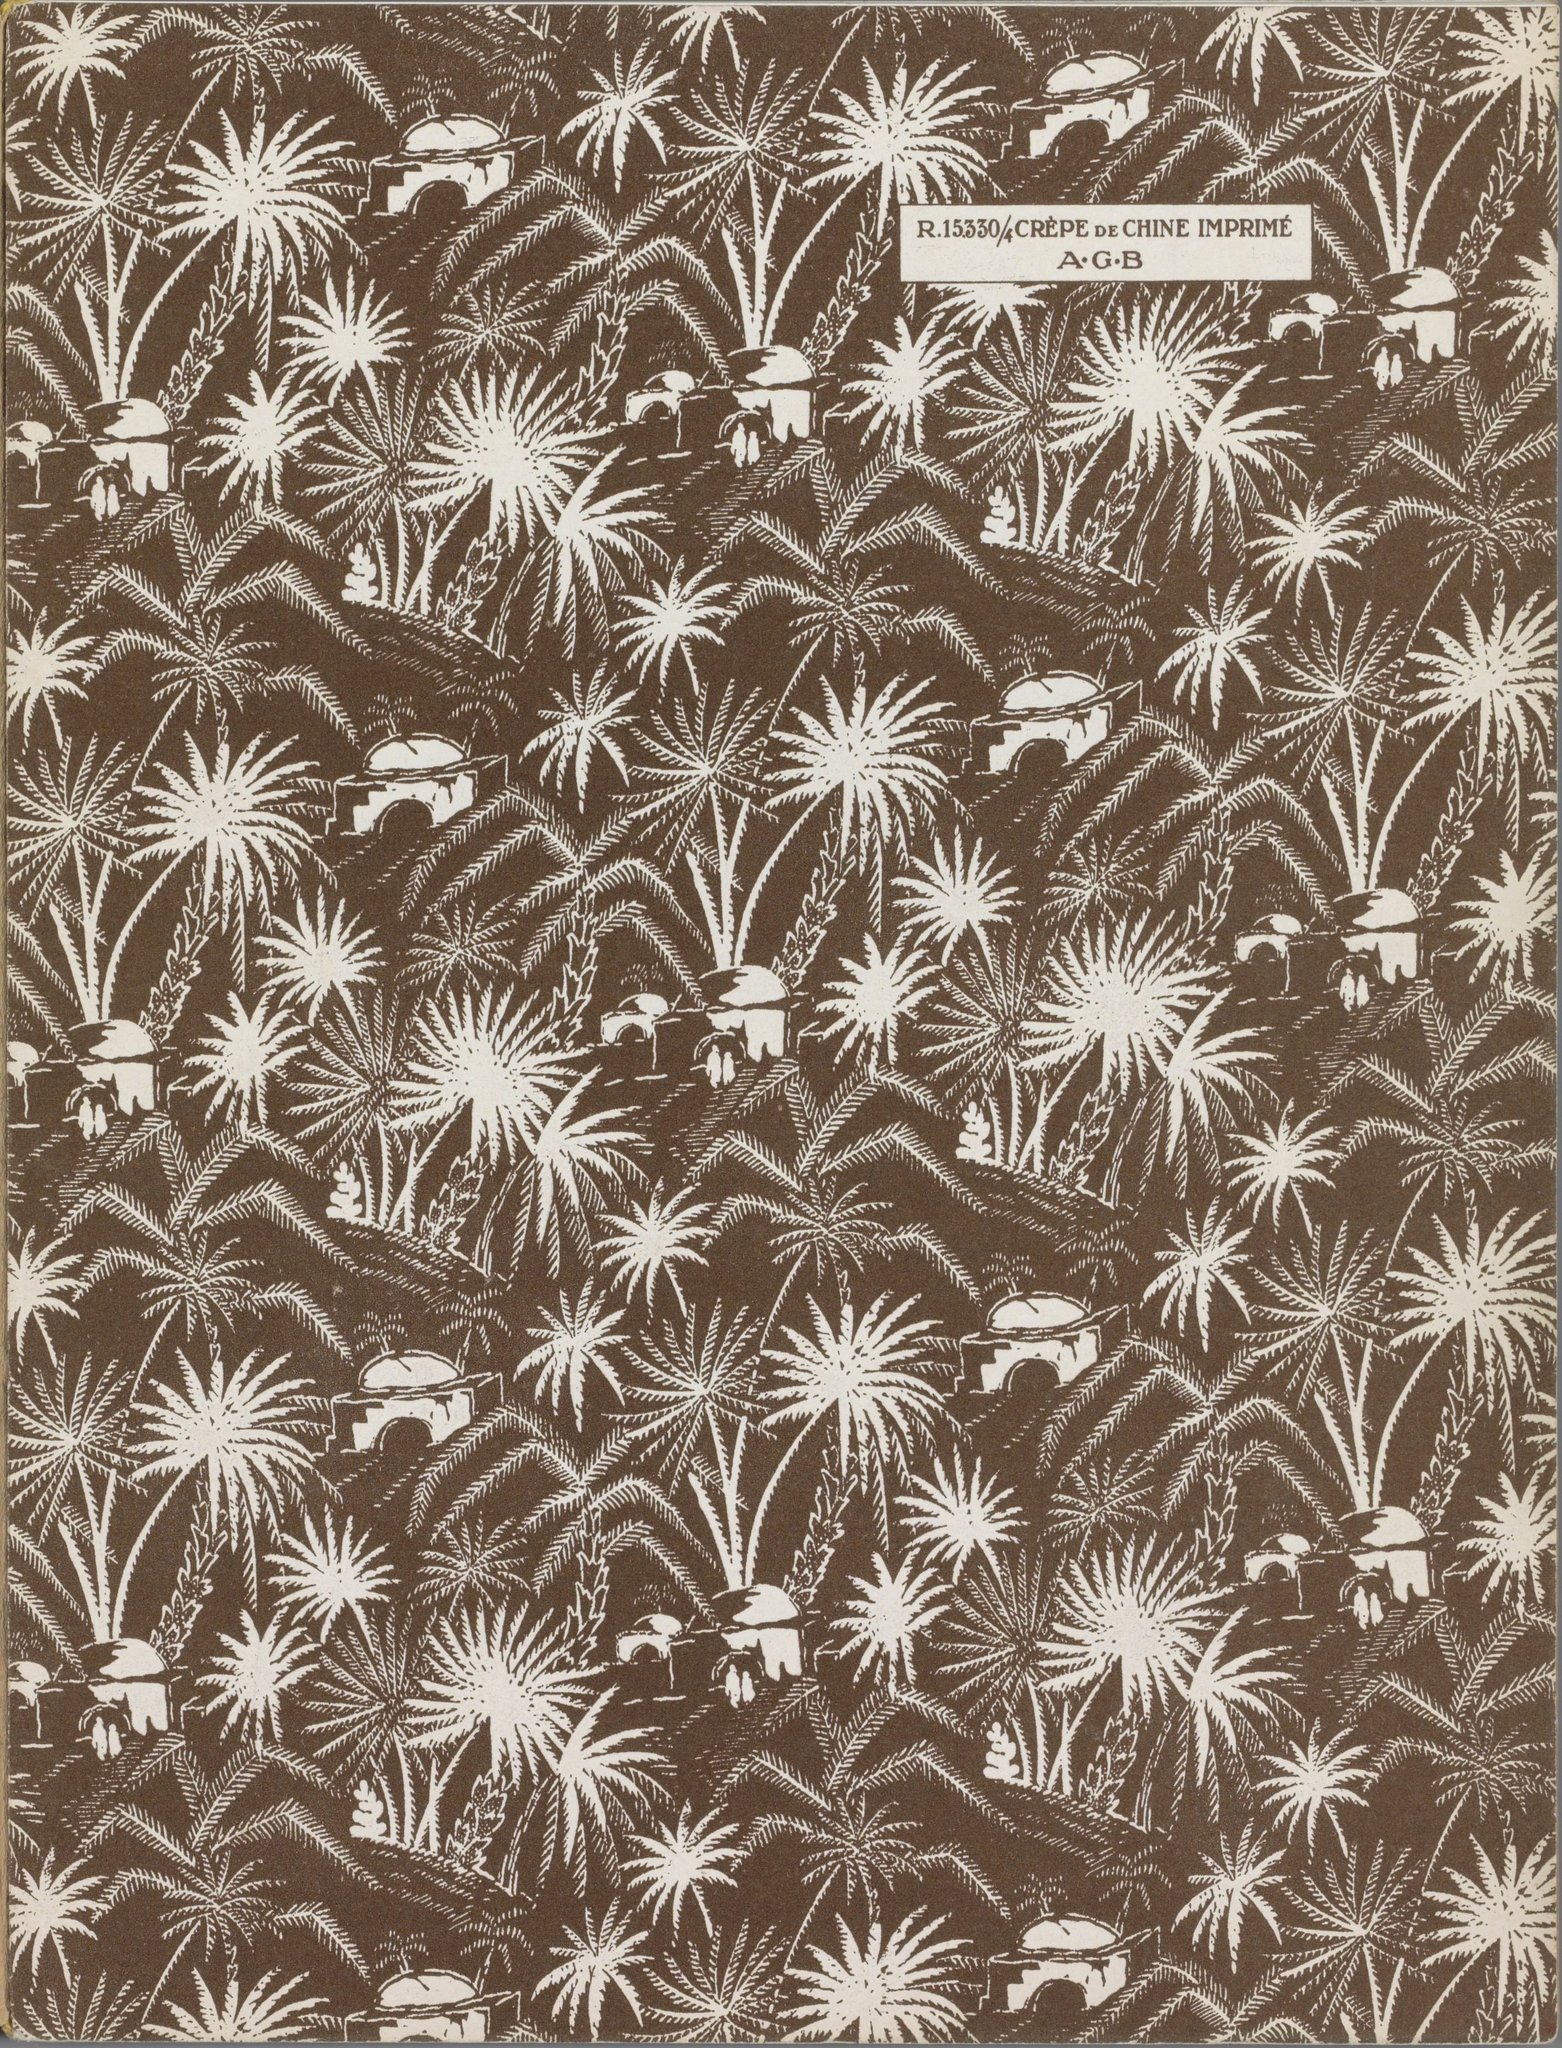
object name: fashion print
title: Endleaves of Art. Goût. Beauté.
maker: charles goy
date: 1931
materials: paper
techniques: photography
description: In November 1921 a new fashion magazine appeared under the name Art. Goût. Beauté. Its initials were taken from Albert Godde Beddin et Cie, a prestigious textile manufacturer and publisher established in Lyon in 1867. Textile designs of the company’s own manufacture were used for the magazine’s decorative endleaves, with the name and number of the pattern noted in a small inset.